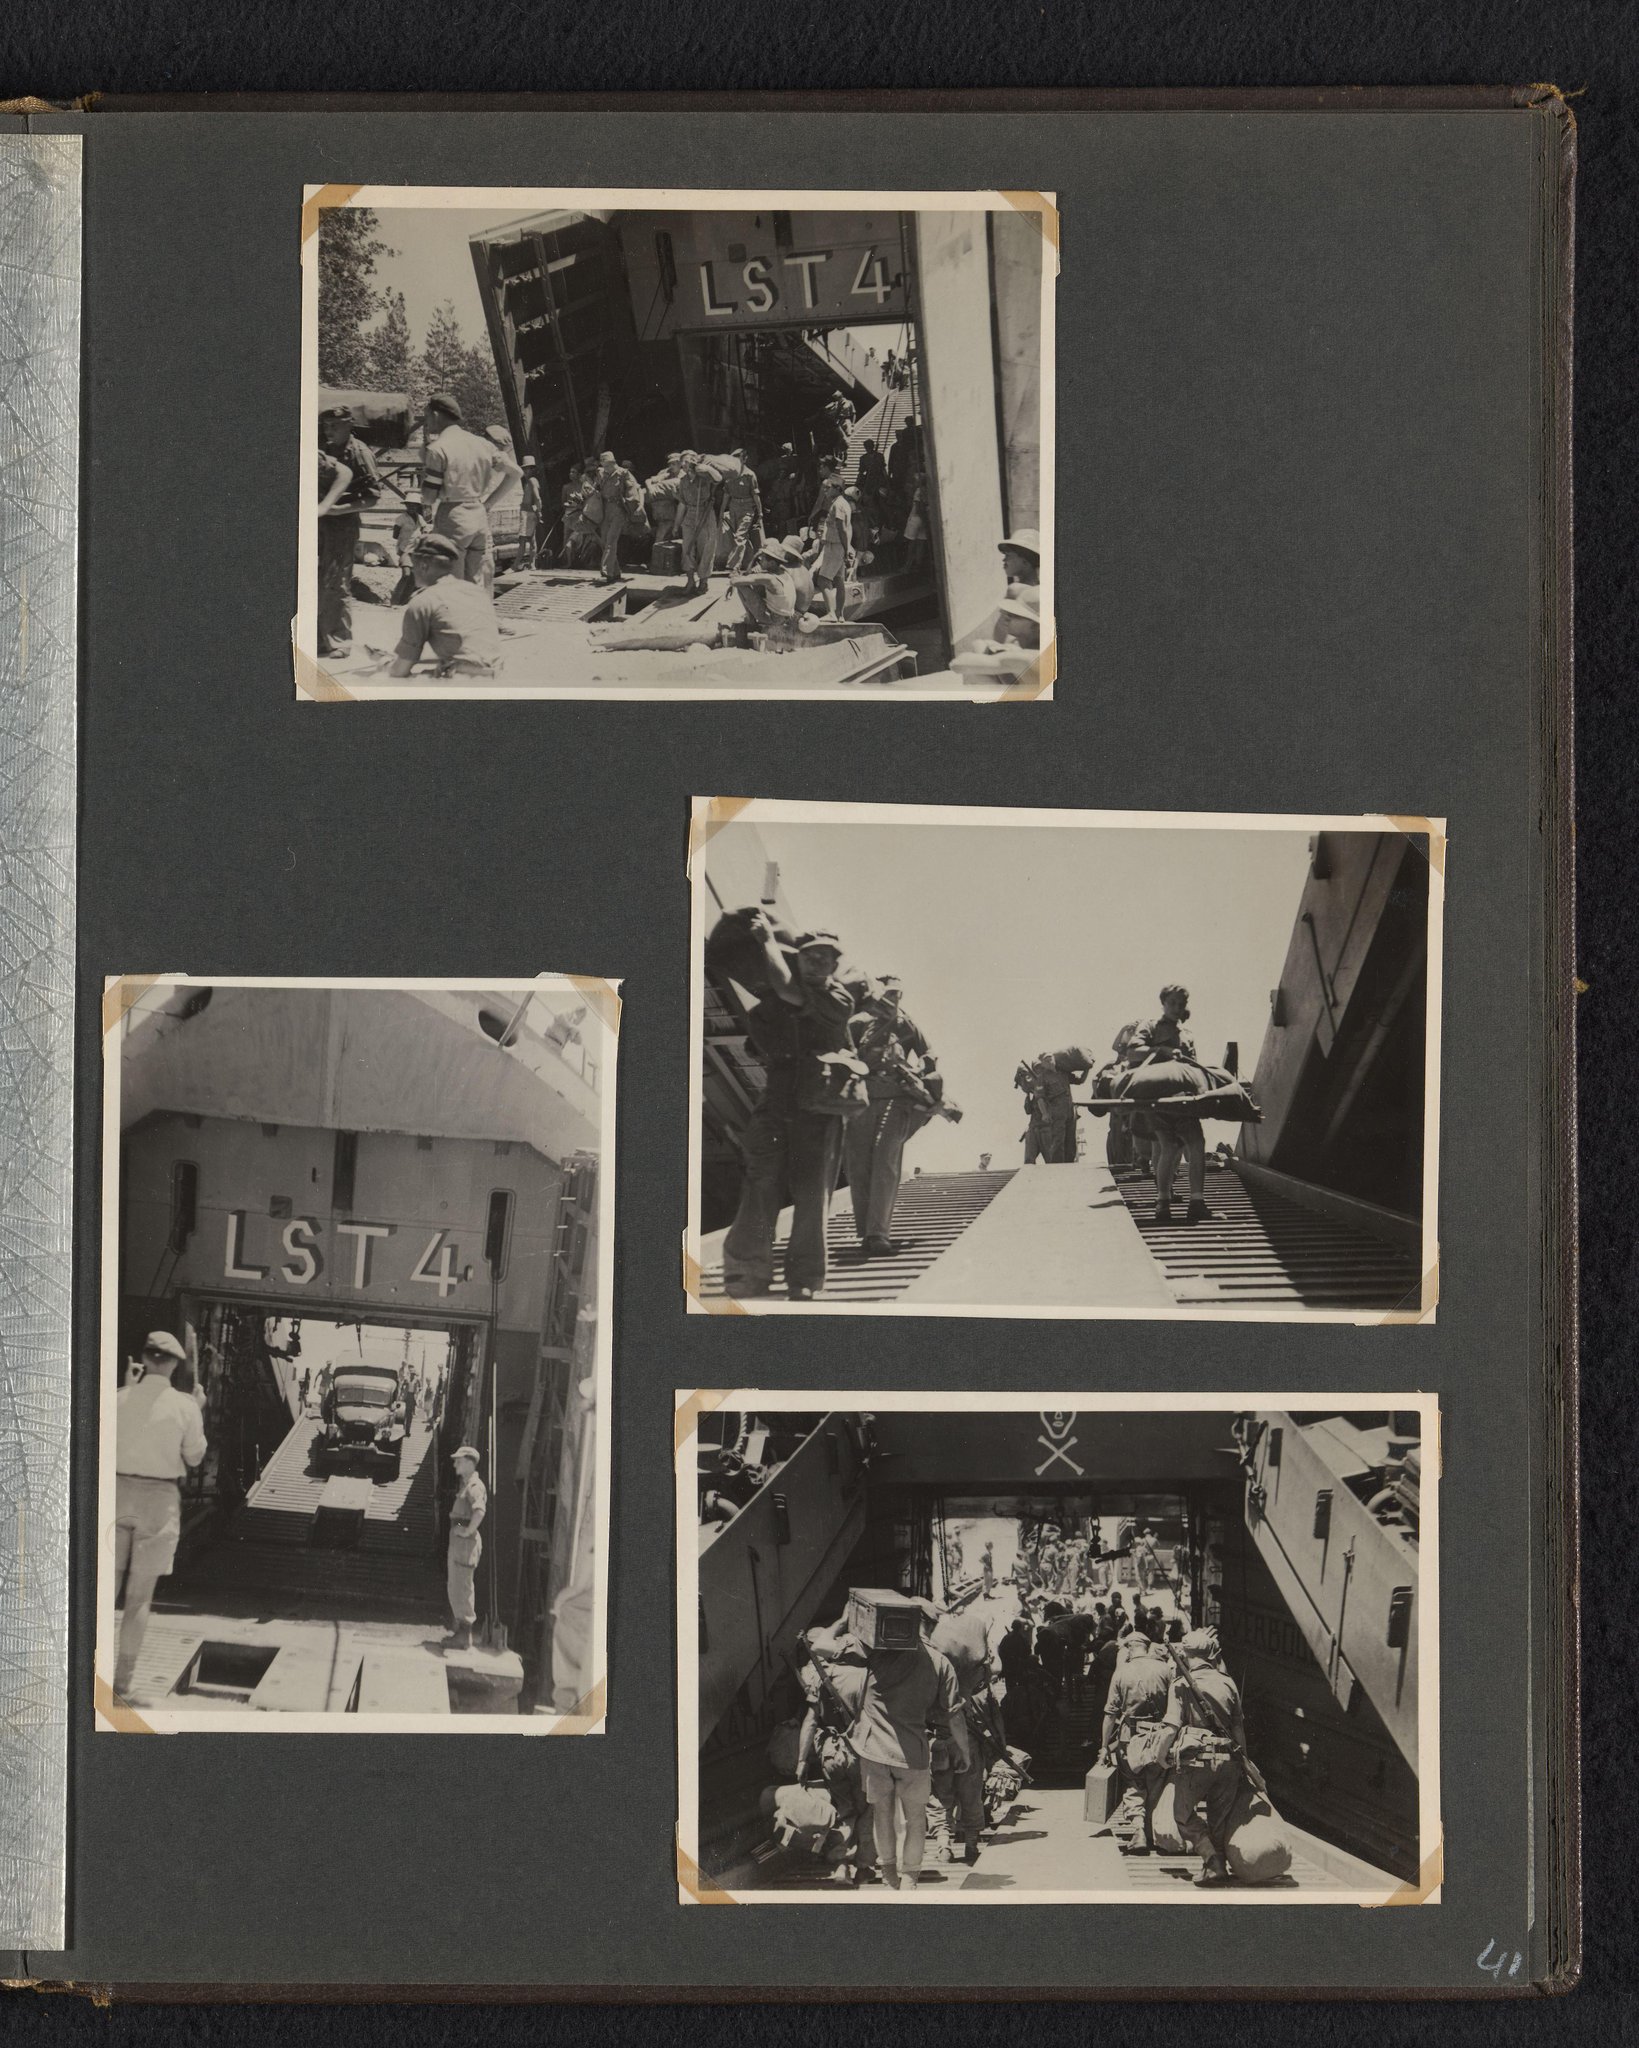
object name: album leaf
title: Ontscheping in Soerabaja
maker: Anonymous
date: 1949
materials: cardboard, photographic support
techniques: gelatin silver print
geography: dutch east indies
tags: troop movements, transportation, dutch east indies, the, surabaya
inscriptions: inscription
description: Albumblad met vier foto's van de manschappen tijdens hun ontscheping in Soerabaja. Vanuit hun vorige standplaats Priok waren ze per schip naar Soerabaja gebracht. Onderdeel van het fotoalbum 'Mijn jaren in Indië' met foto's over de militaire acties in Nederlands-Indië.